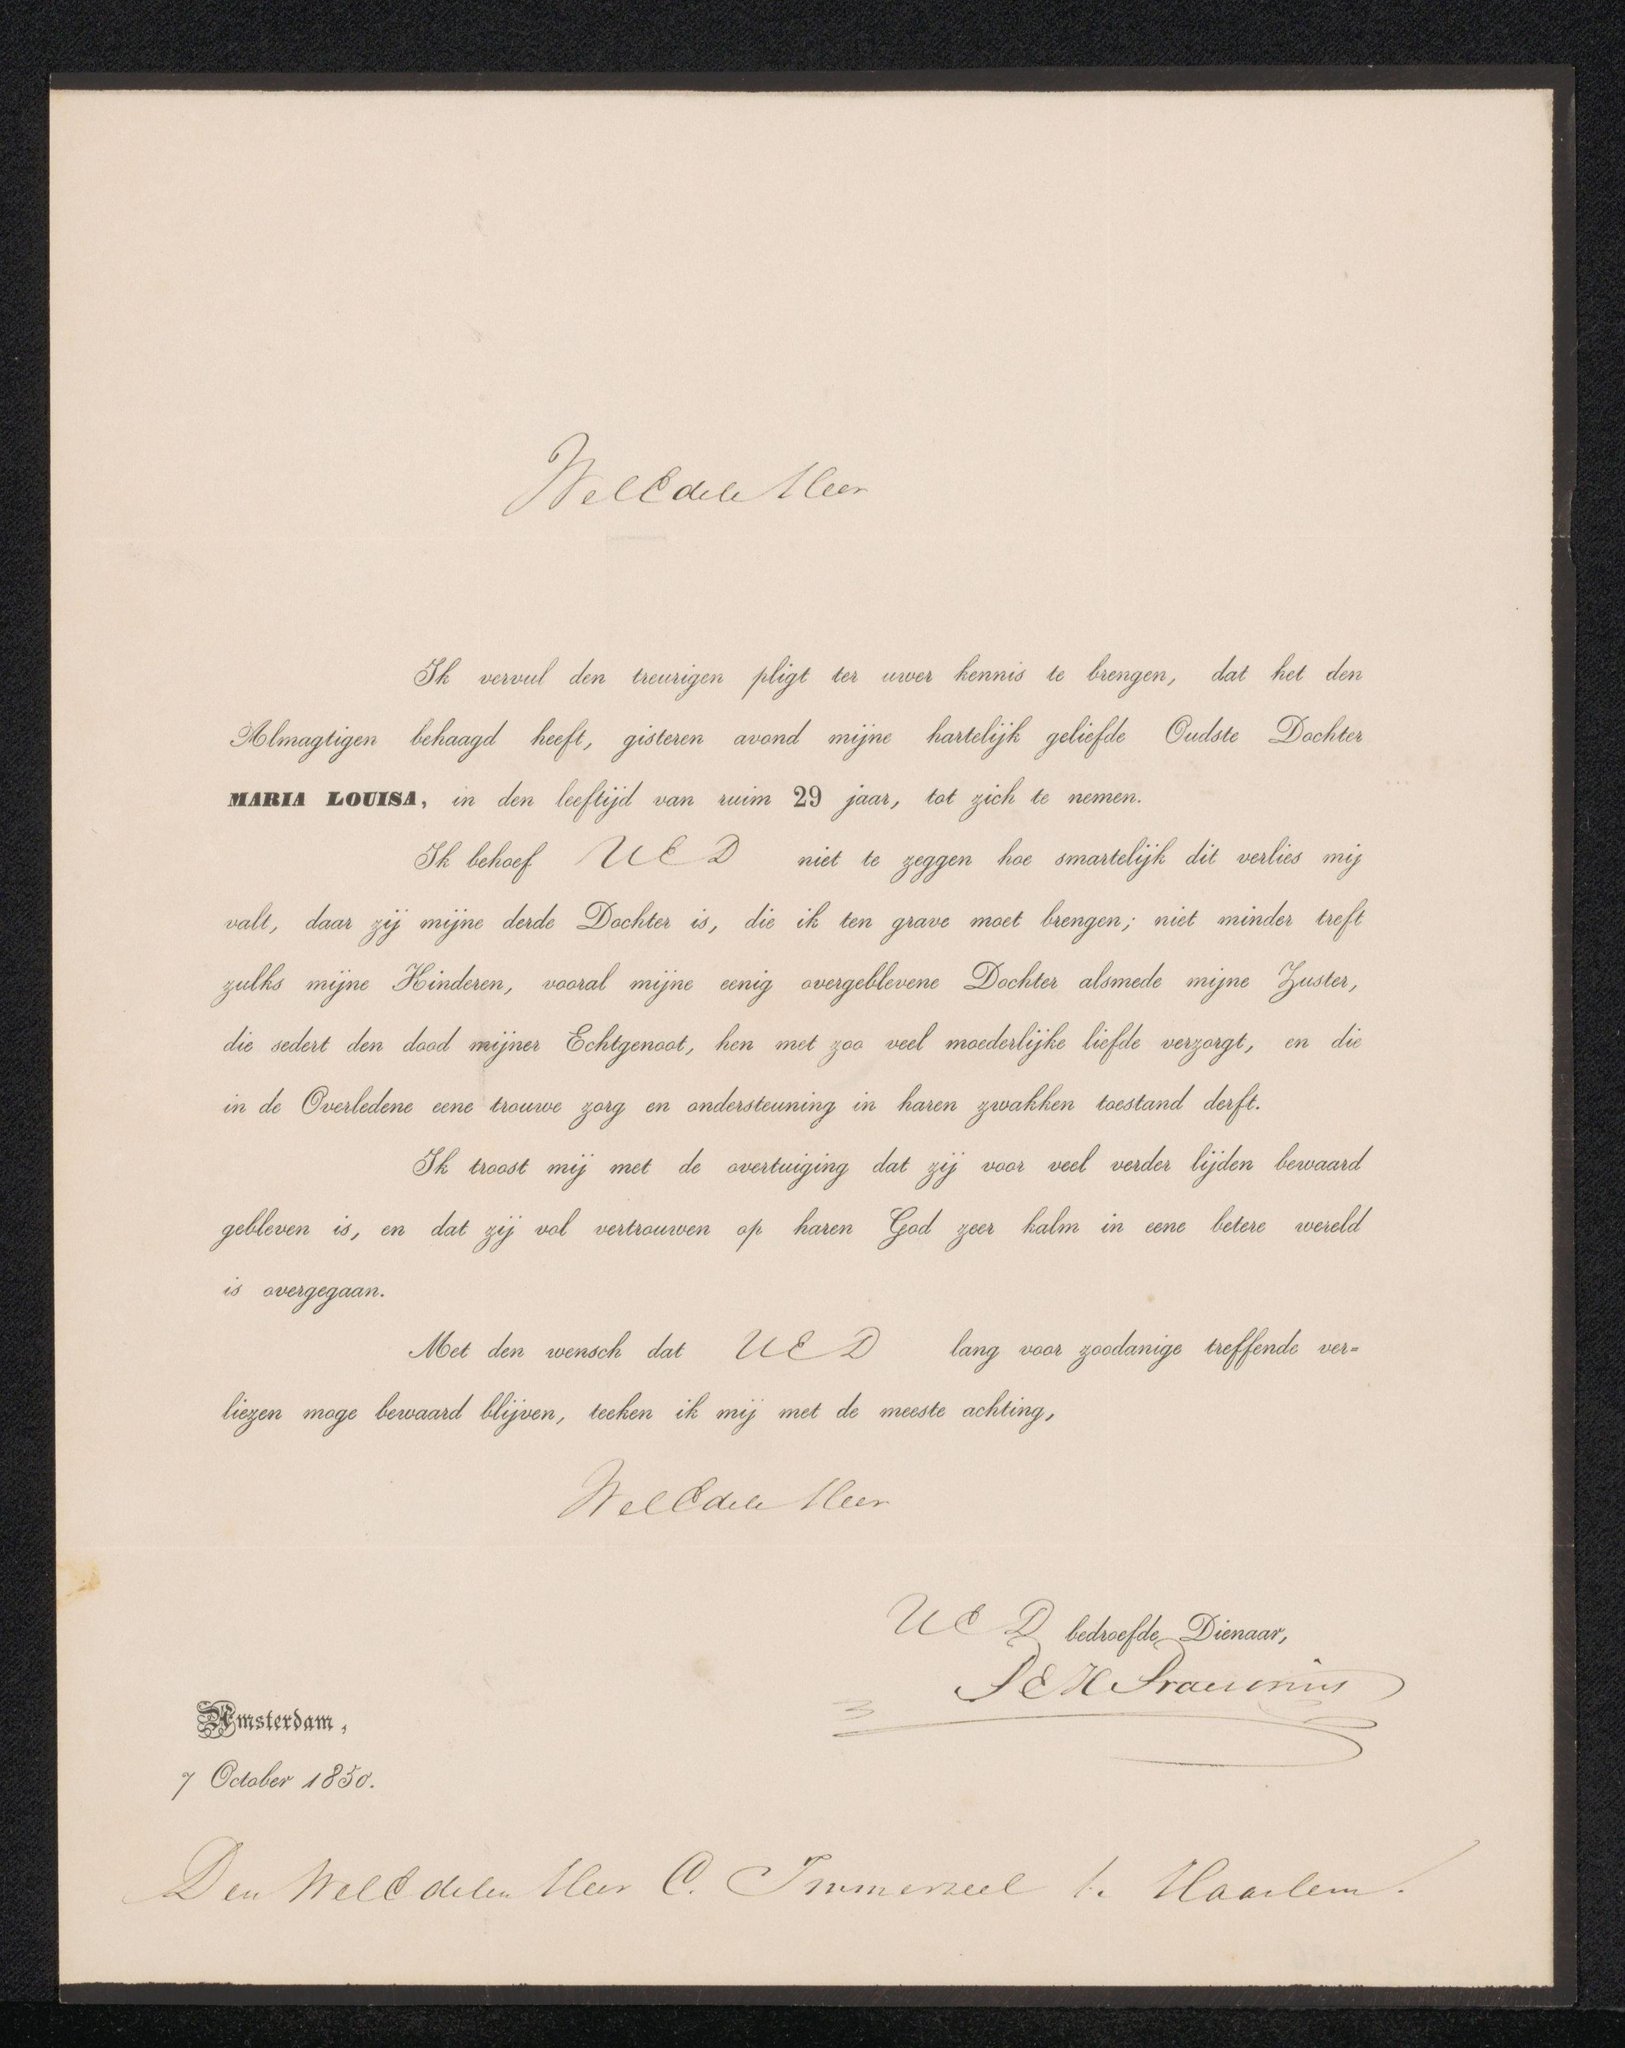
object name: letter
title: Brief aan Christiaan Immerzeel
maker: pieter ernst hendrik praetorius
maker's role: draughtsman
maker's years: 1791-1876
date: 1850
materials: ink, paper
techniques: pen, printing, writing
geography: amsterdam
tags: print maker, christiaan immerzeel, passions, emotions, affections, family life